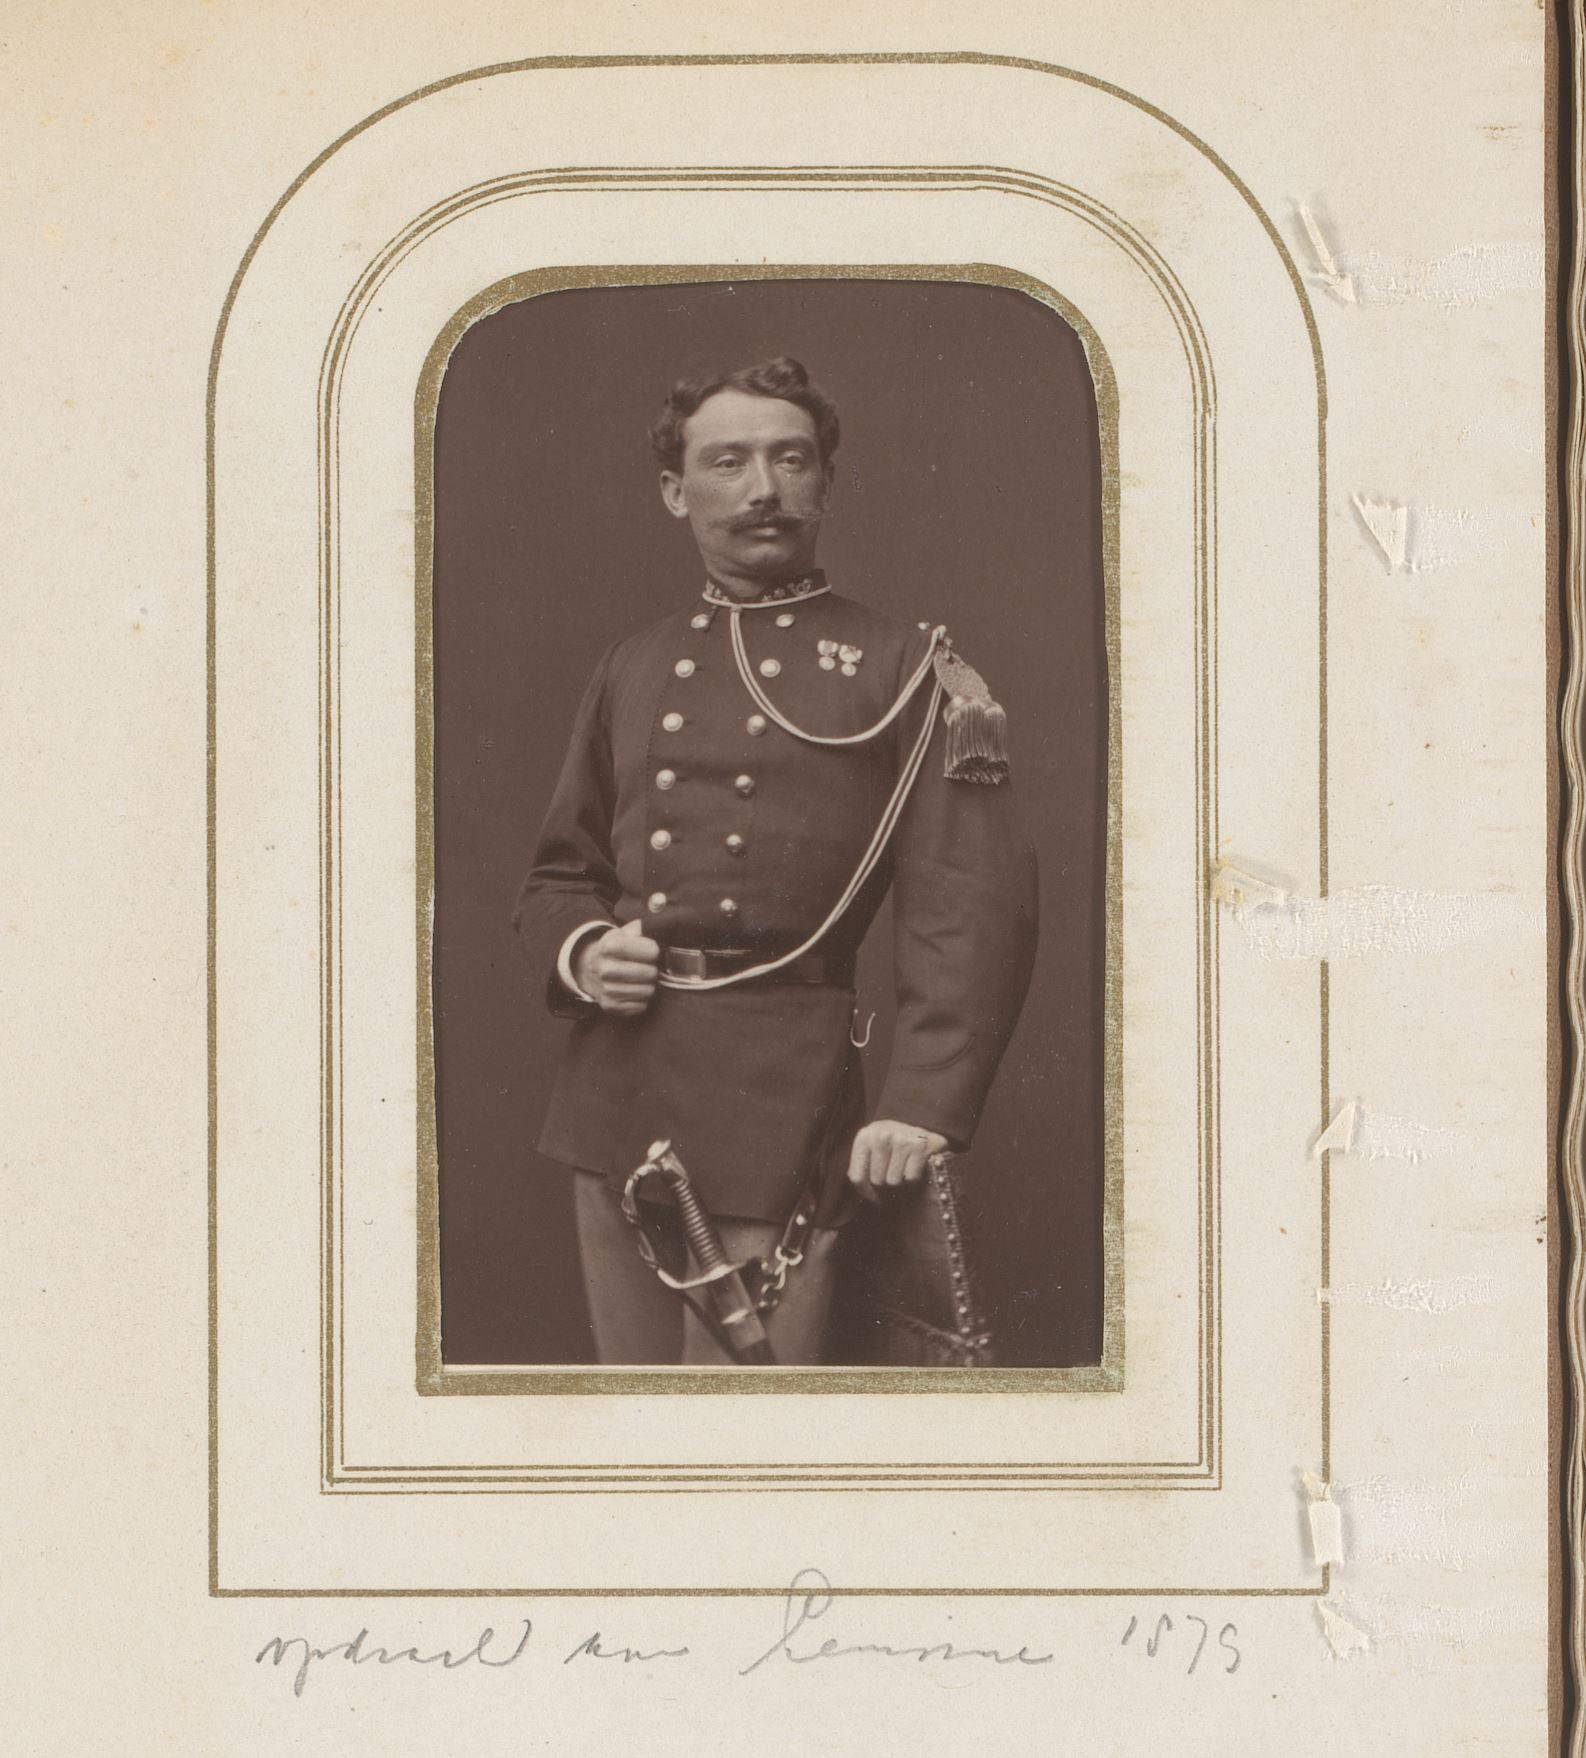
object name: album leaf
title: Portret van een man in uniform met zwaard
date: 1873-1879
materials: cardboard, paper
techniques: carbon print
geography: brussels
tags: historical persons, hacking and thrusting weapons: sword, (military) uniforms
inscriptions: annotation: ‘A mon ami le/ Colonel Lemoine/ souvenir de [...] décédé [haut d'Afrique ...] le 19/ Decembre 187[9]/ [...]’, annotation: ‘opdracht aan Lemoine 1879’, inscription: ‘procede inalterable/ Photographie au Charbon/ exposition universelle vienne 1873/ Géruzet Frères/ Photographes de S.M. la Reine des Belges/ 27, Rue de l'Ecuyer/ Bruxelles’